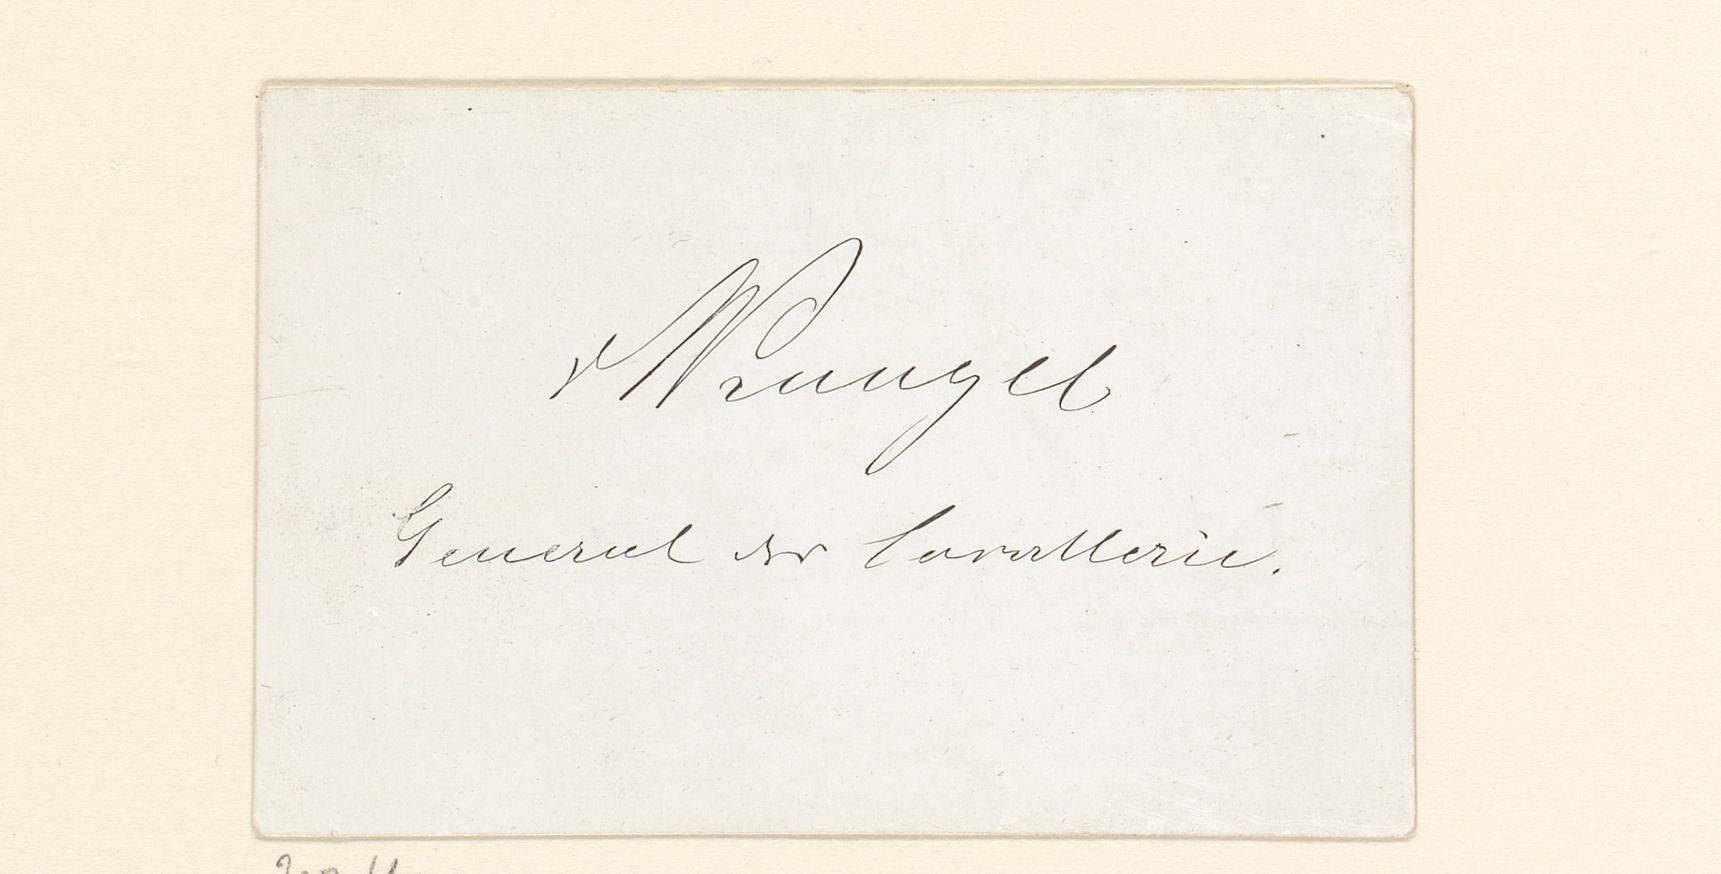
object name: visiting card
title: Visitekaart van Friedrich von Wrangel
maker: Anonymous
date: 1848-1856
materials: ink, paper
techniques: pen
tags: visiting-card, calling-card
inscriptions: collector's mark: Lugt 2228, collector's mark: Lugt 2760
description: Handgeschreven kaart, van mogelijk Friedrich von Wrangel, die van 1848 tot 1856 General der Kavallerie van het Pruissische leger was.